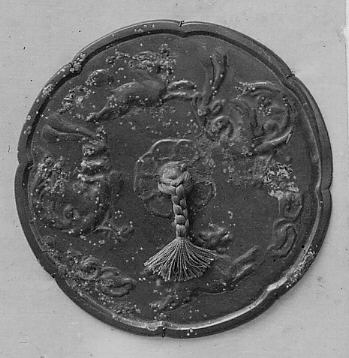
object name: mirror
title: Mirror with paired birds and lions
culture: chinese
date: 701-800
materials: bronze